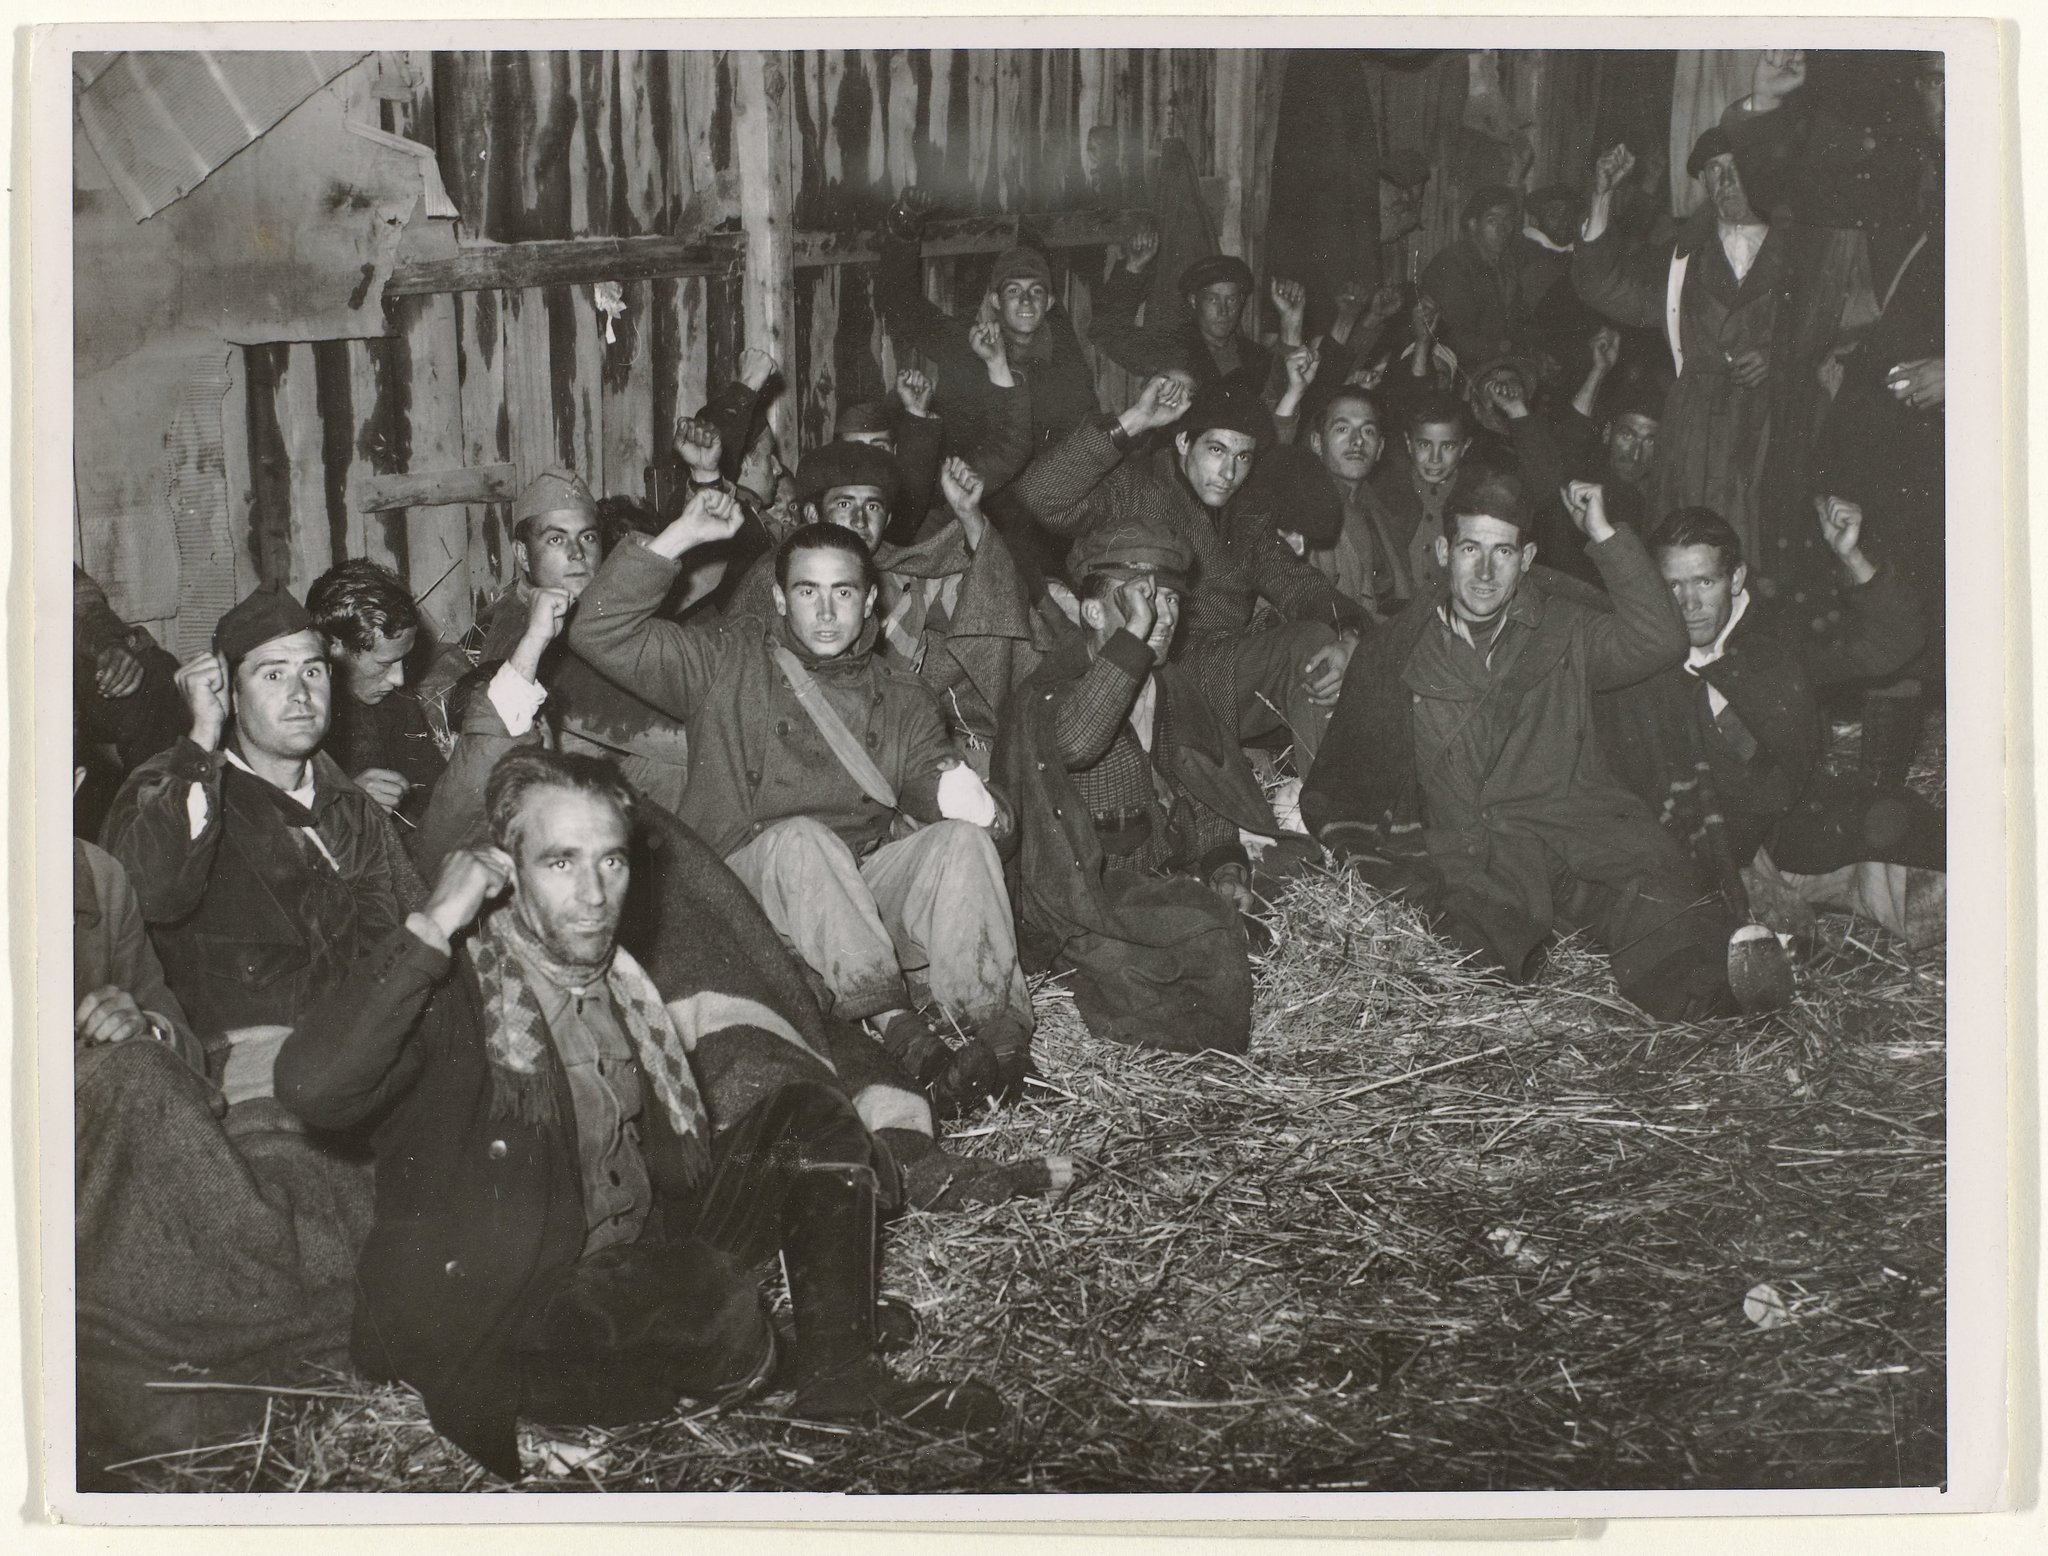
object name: news photograph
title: Militiamen still defy Franco with communist salute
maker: Anonymous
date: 1939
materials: photographic support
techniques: gelatin silver print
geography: france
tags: france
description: Een groep rustende republikeinse soldaten in een boerenschuur over de Franse grens bij Le Perthus brengt met gebalde vuisten het communistische saluut, 31 januari 1939, tijdens de Spaanse Burgeroorlog. Op de achterzijde twee stempels en blaadje met perstekst in het Engels.